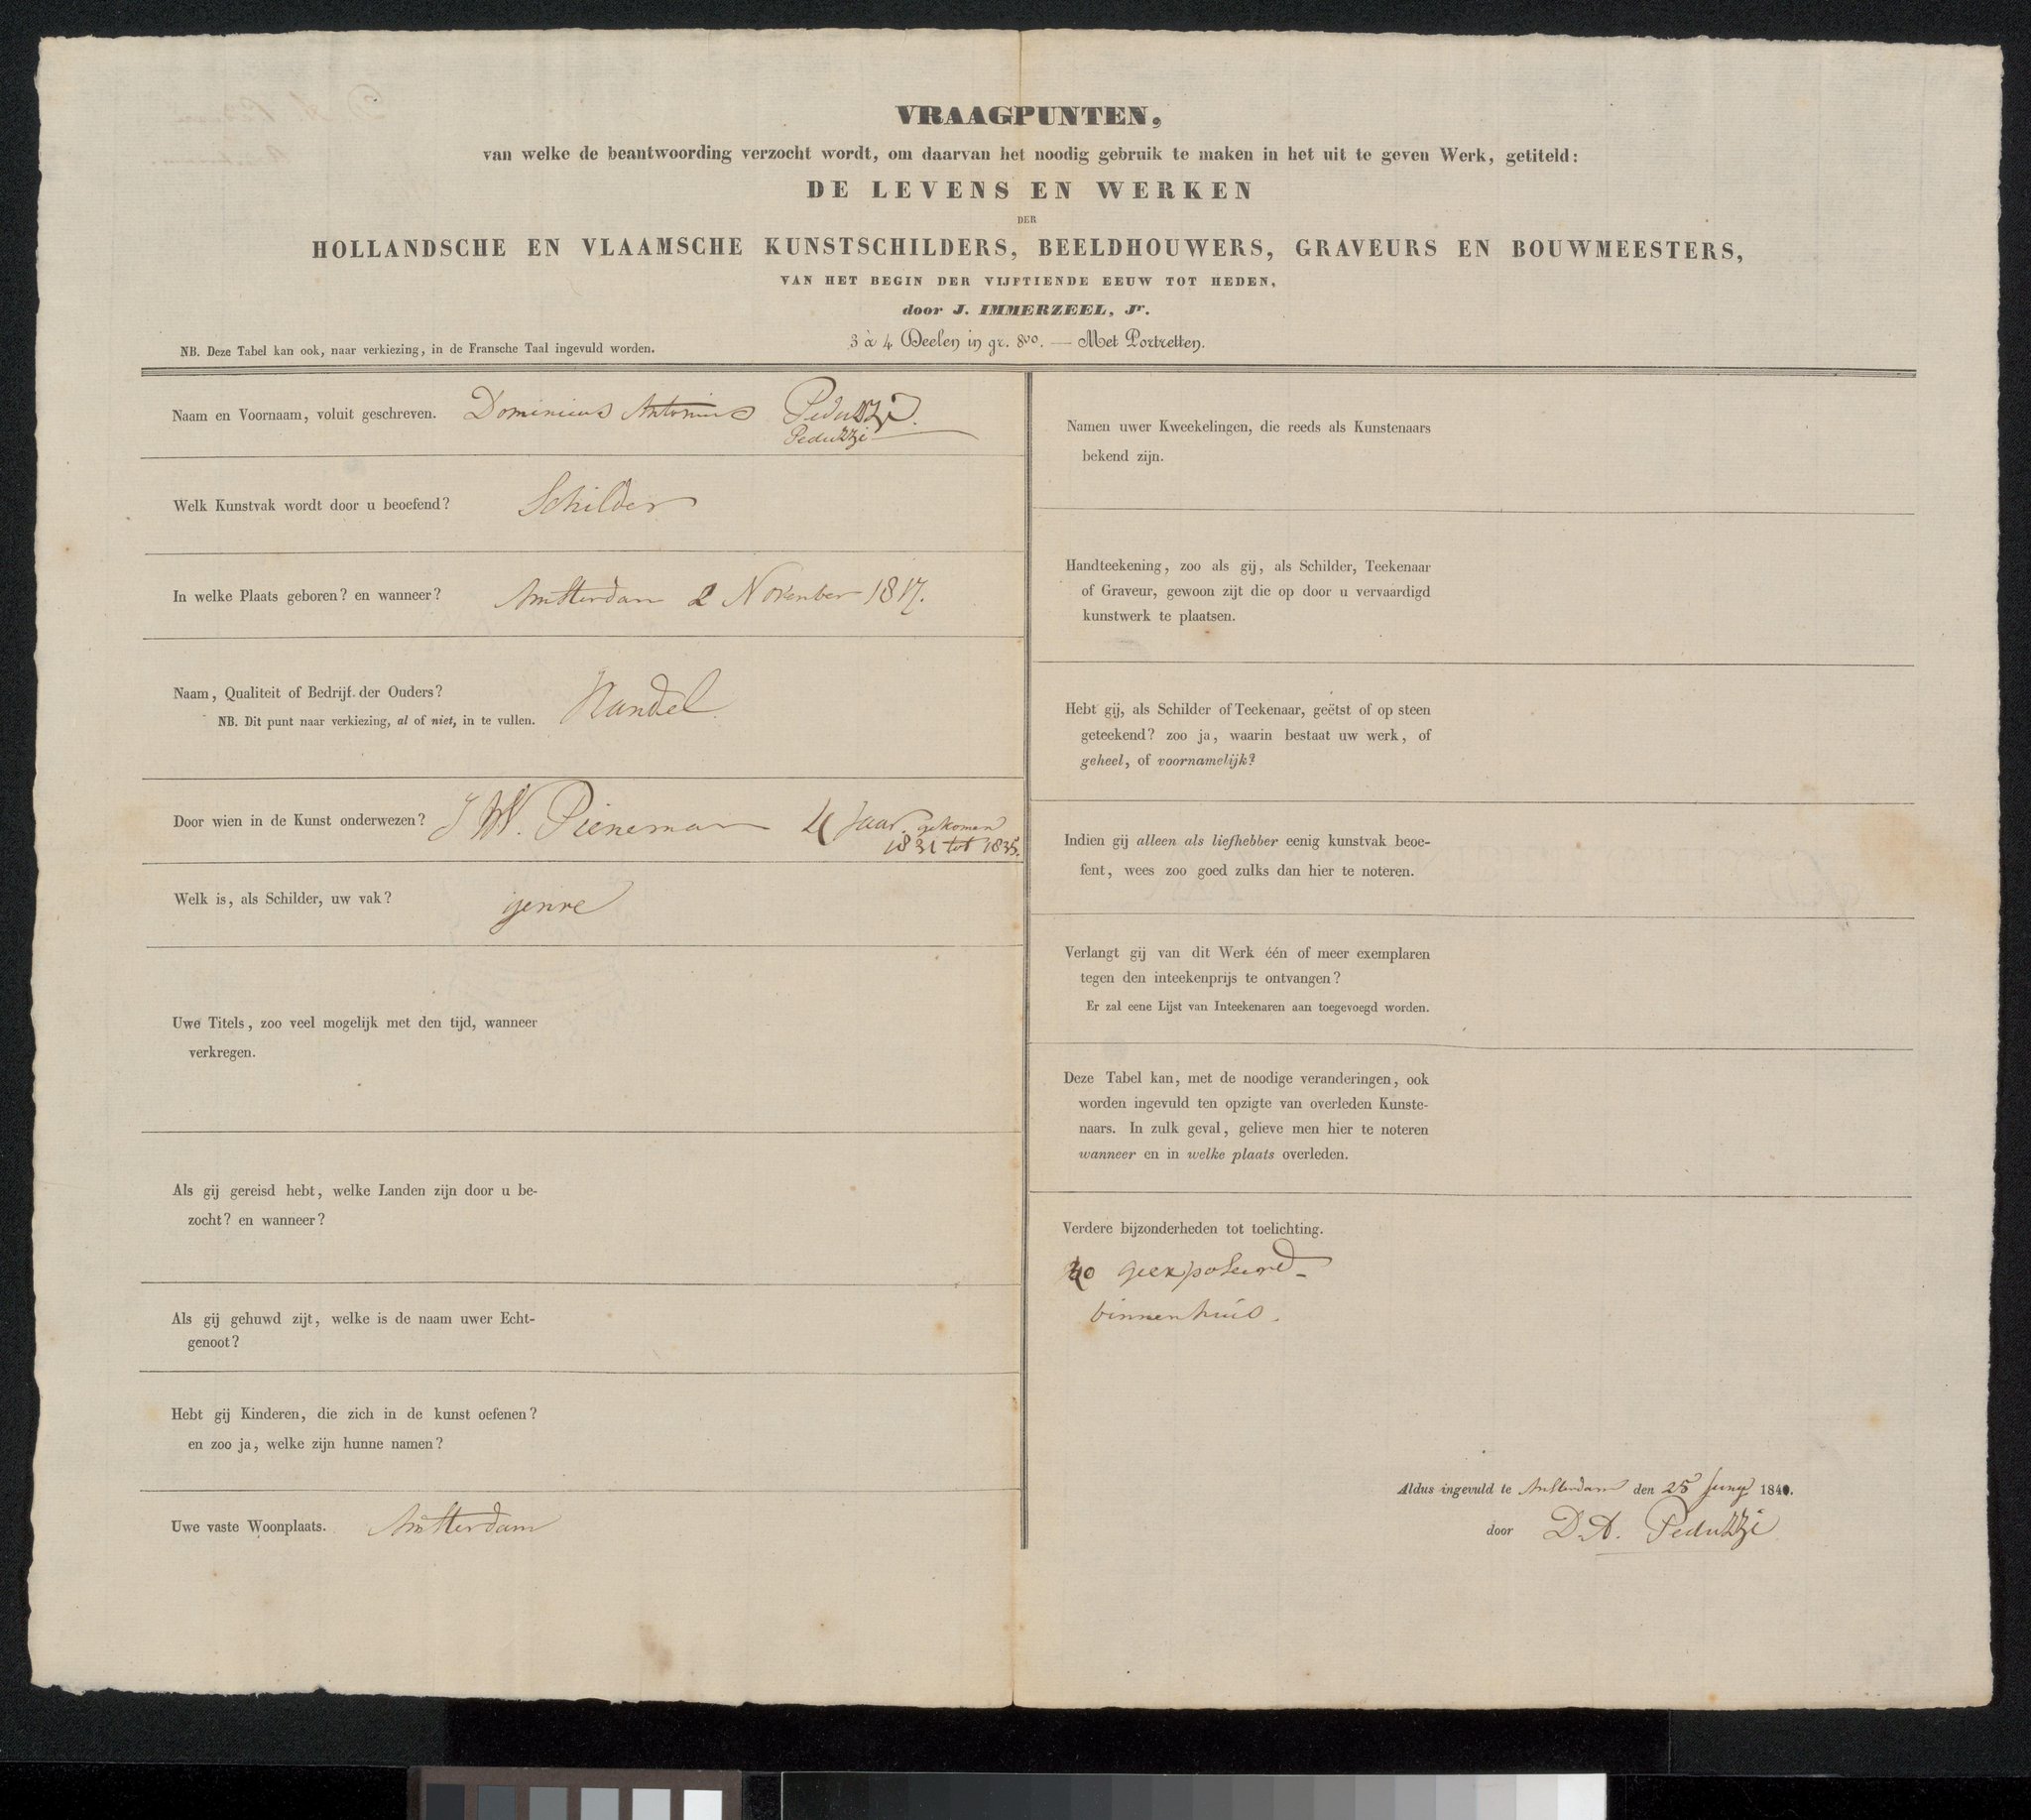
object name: questionnaire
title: Enquêteformulier ingevuld door Dominicus Anthonius Paduzzi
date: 1841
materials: ink, paper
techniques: pen, printing, writing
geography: amsterdam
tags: amsterdam, vienna, print maker, draughtsman, dominicus anthonius peduzzi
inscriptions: inscription: ‘Vraagpunten,/ van welke de beantwoording verzocht wordt, om daarvan het noodig gebruik te maken in het uit te geven Werk, getiteld: De levens en werken/ der Hollandsche en Vlaamsche kunstschilders, beeldhouwers,/ graveurs en bouwmeesters, van het begin der vijftiende eeuw tot heden/ door J. Immerzeel, Jr.’, watermark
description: Opgenomen in: Immerzeel, J. Jr., De levens en werken der Hollandsche en Vlaamsche kunstschilders, beeldhouwers, graveurs en bouwmeesters, van het begin der vijftiende eeuw tot heden, Amsterdam: J.C. van Kesteren, 1842-1843.